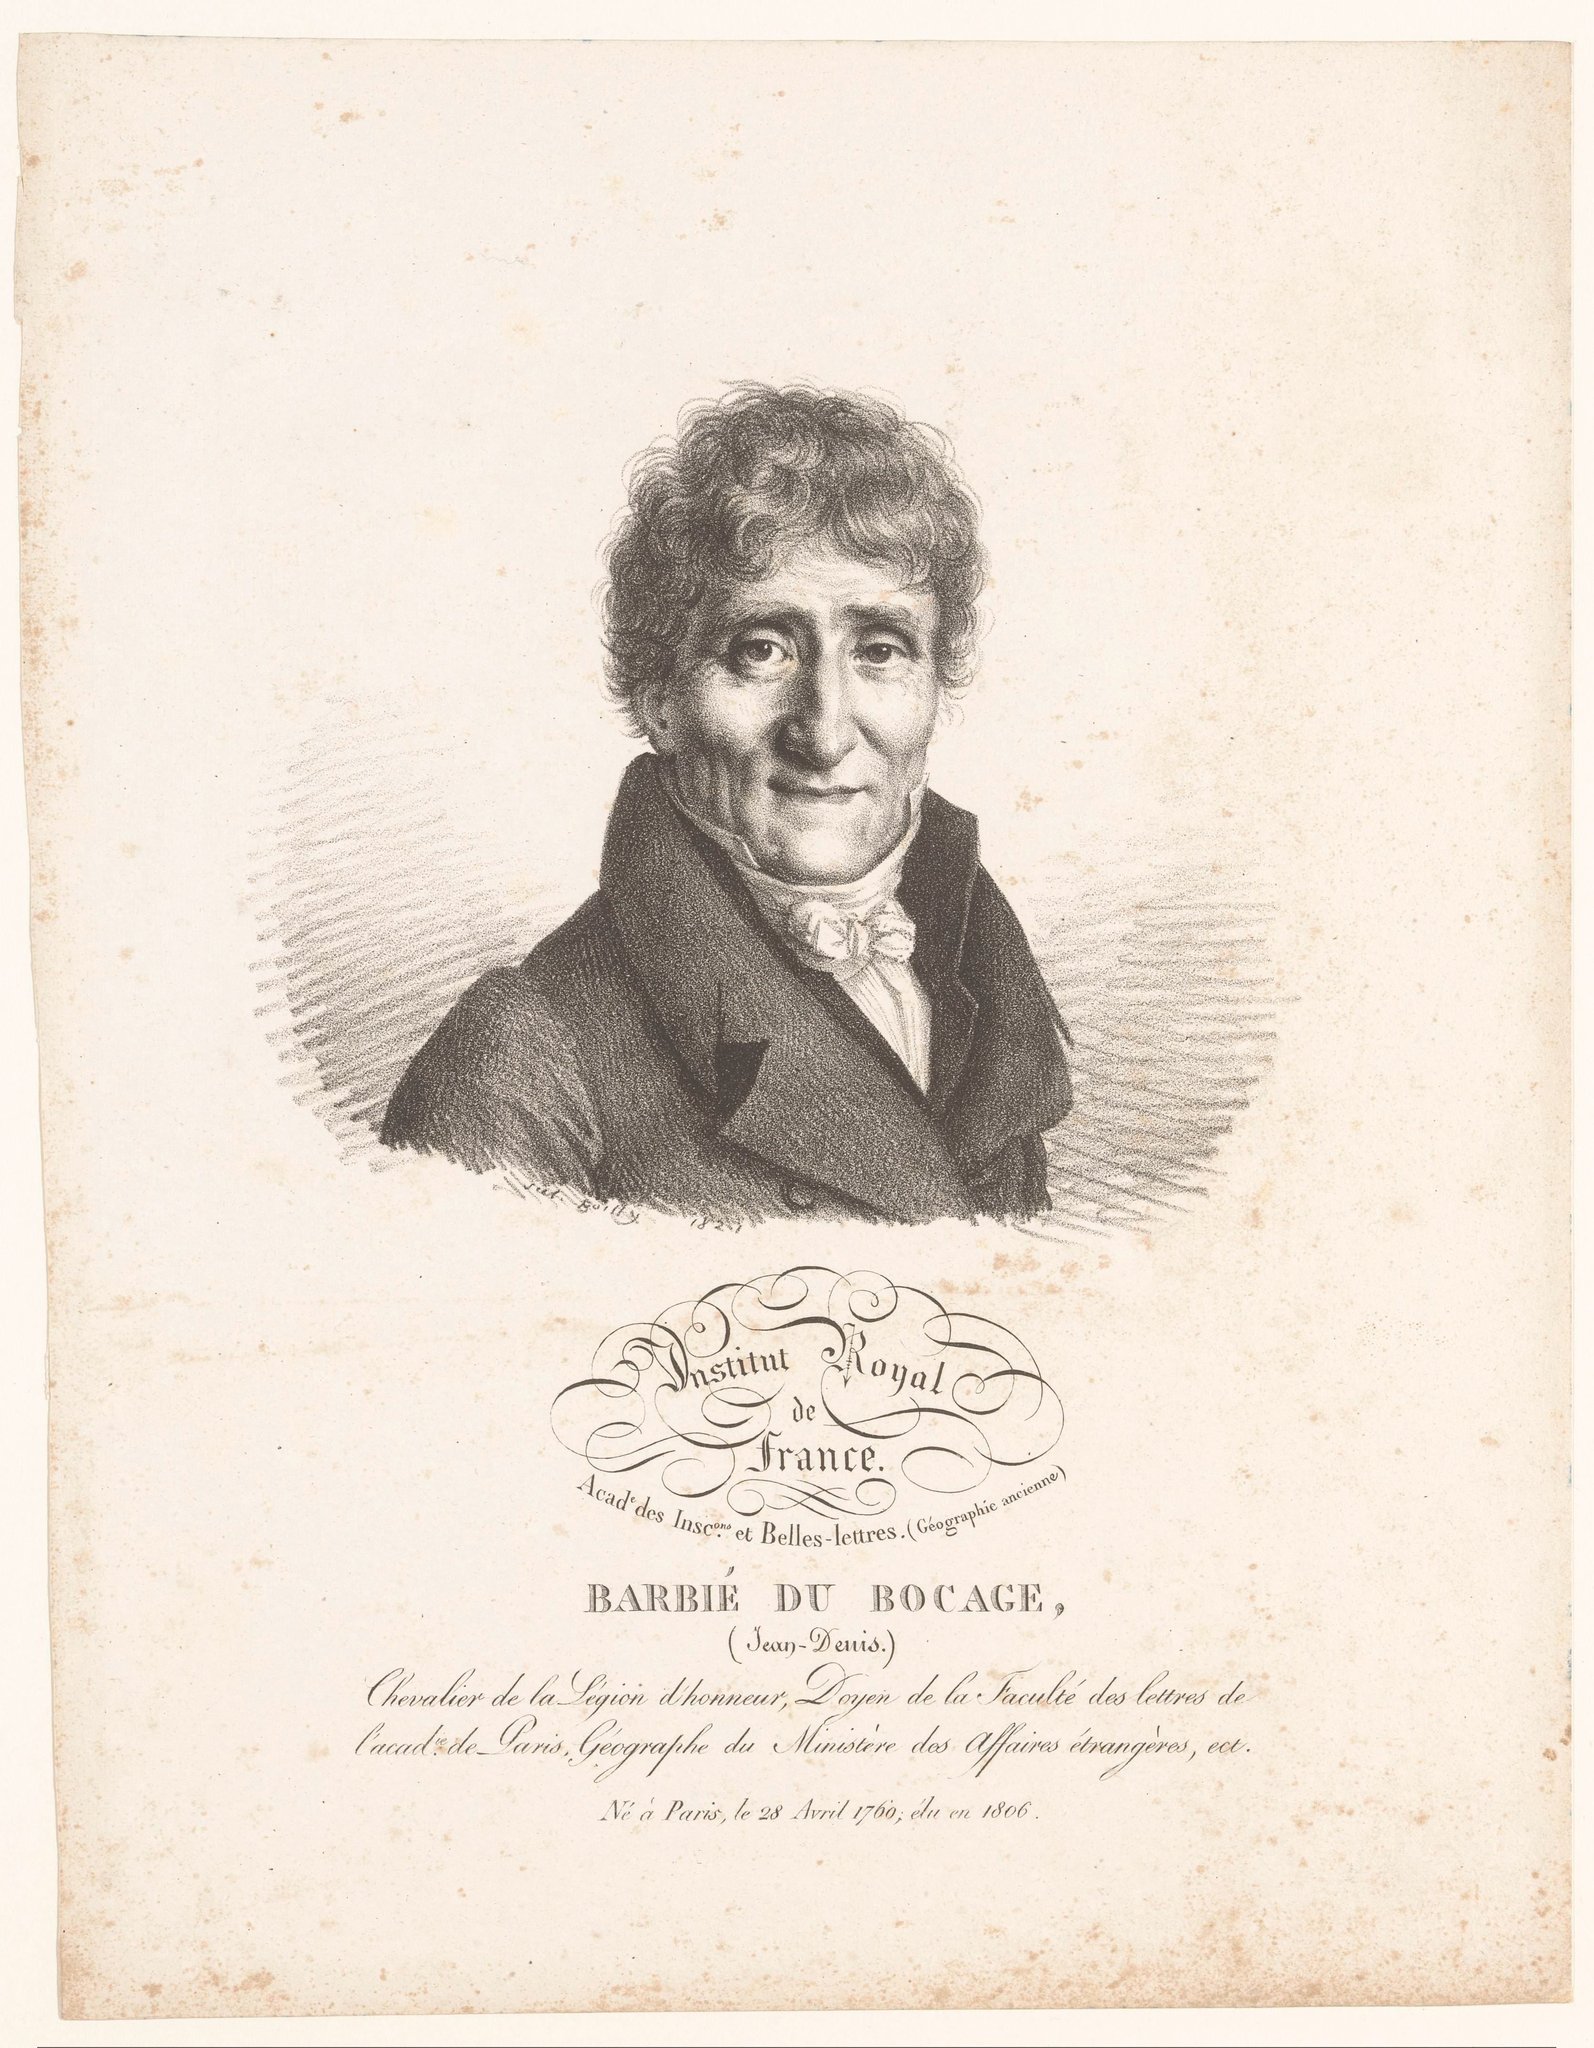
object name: print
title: Iconographie de l'Institut Royal de France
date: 1821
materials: paper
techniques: lithograph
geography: paris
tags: paris, historical persons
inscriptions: collector's mark: Lugt 2228a